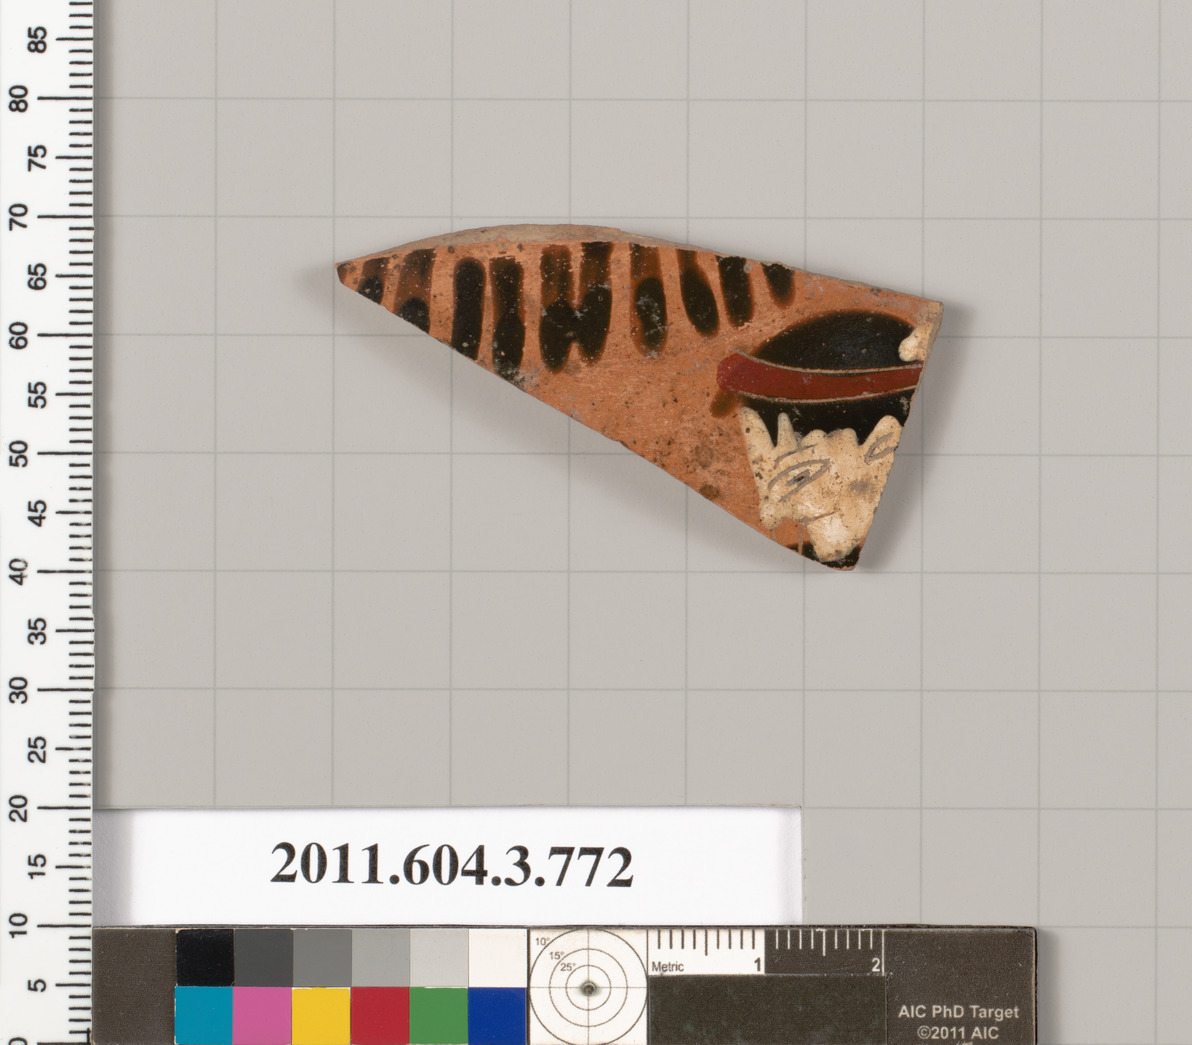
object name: oinochoe fragment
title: Terracotta fragment of an oinochoe (jug)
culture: greek, attic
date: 534-468 BCE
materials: terracotta